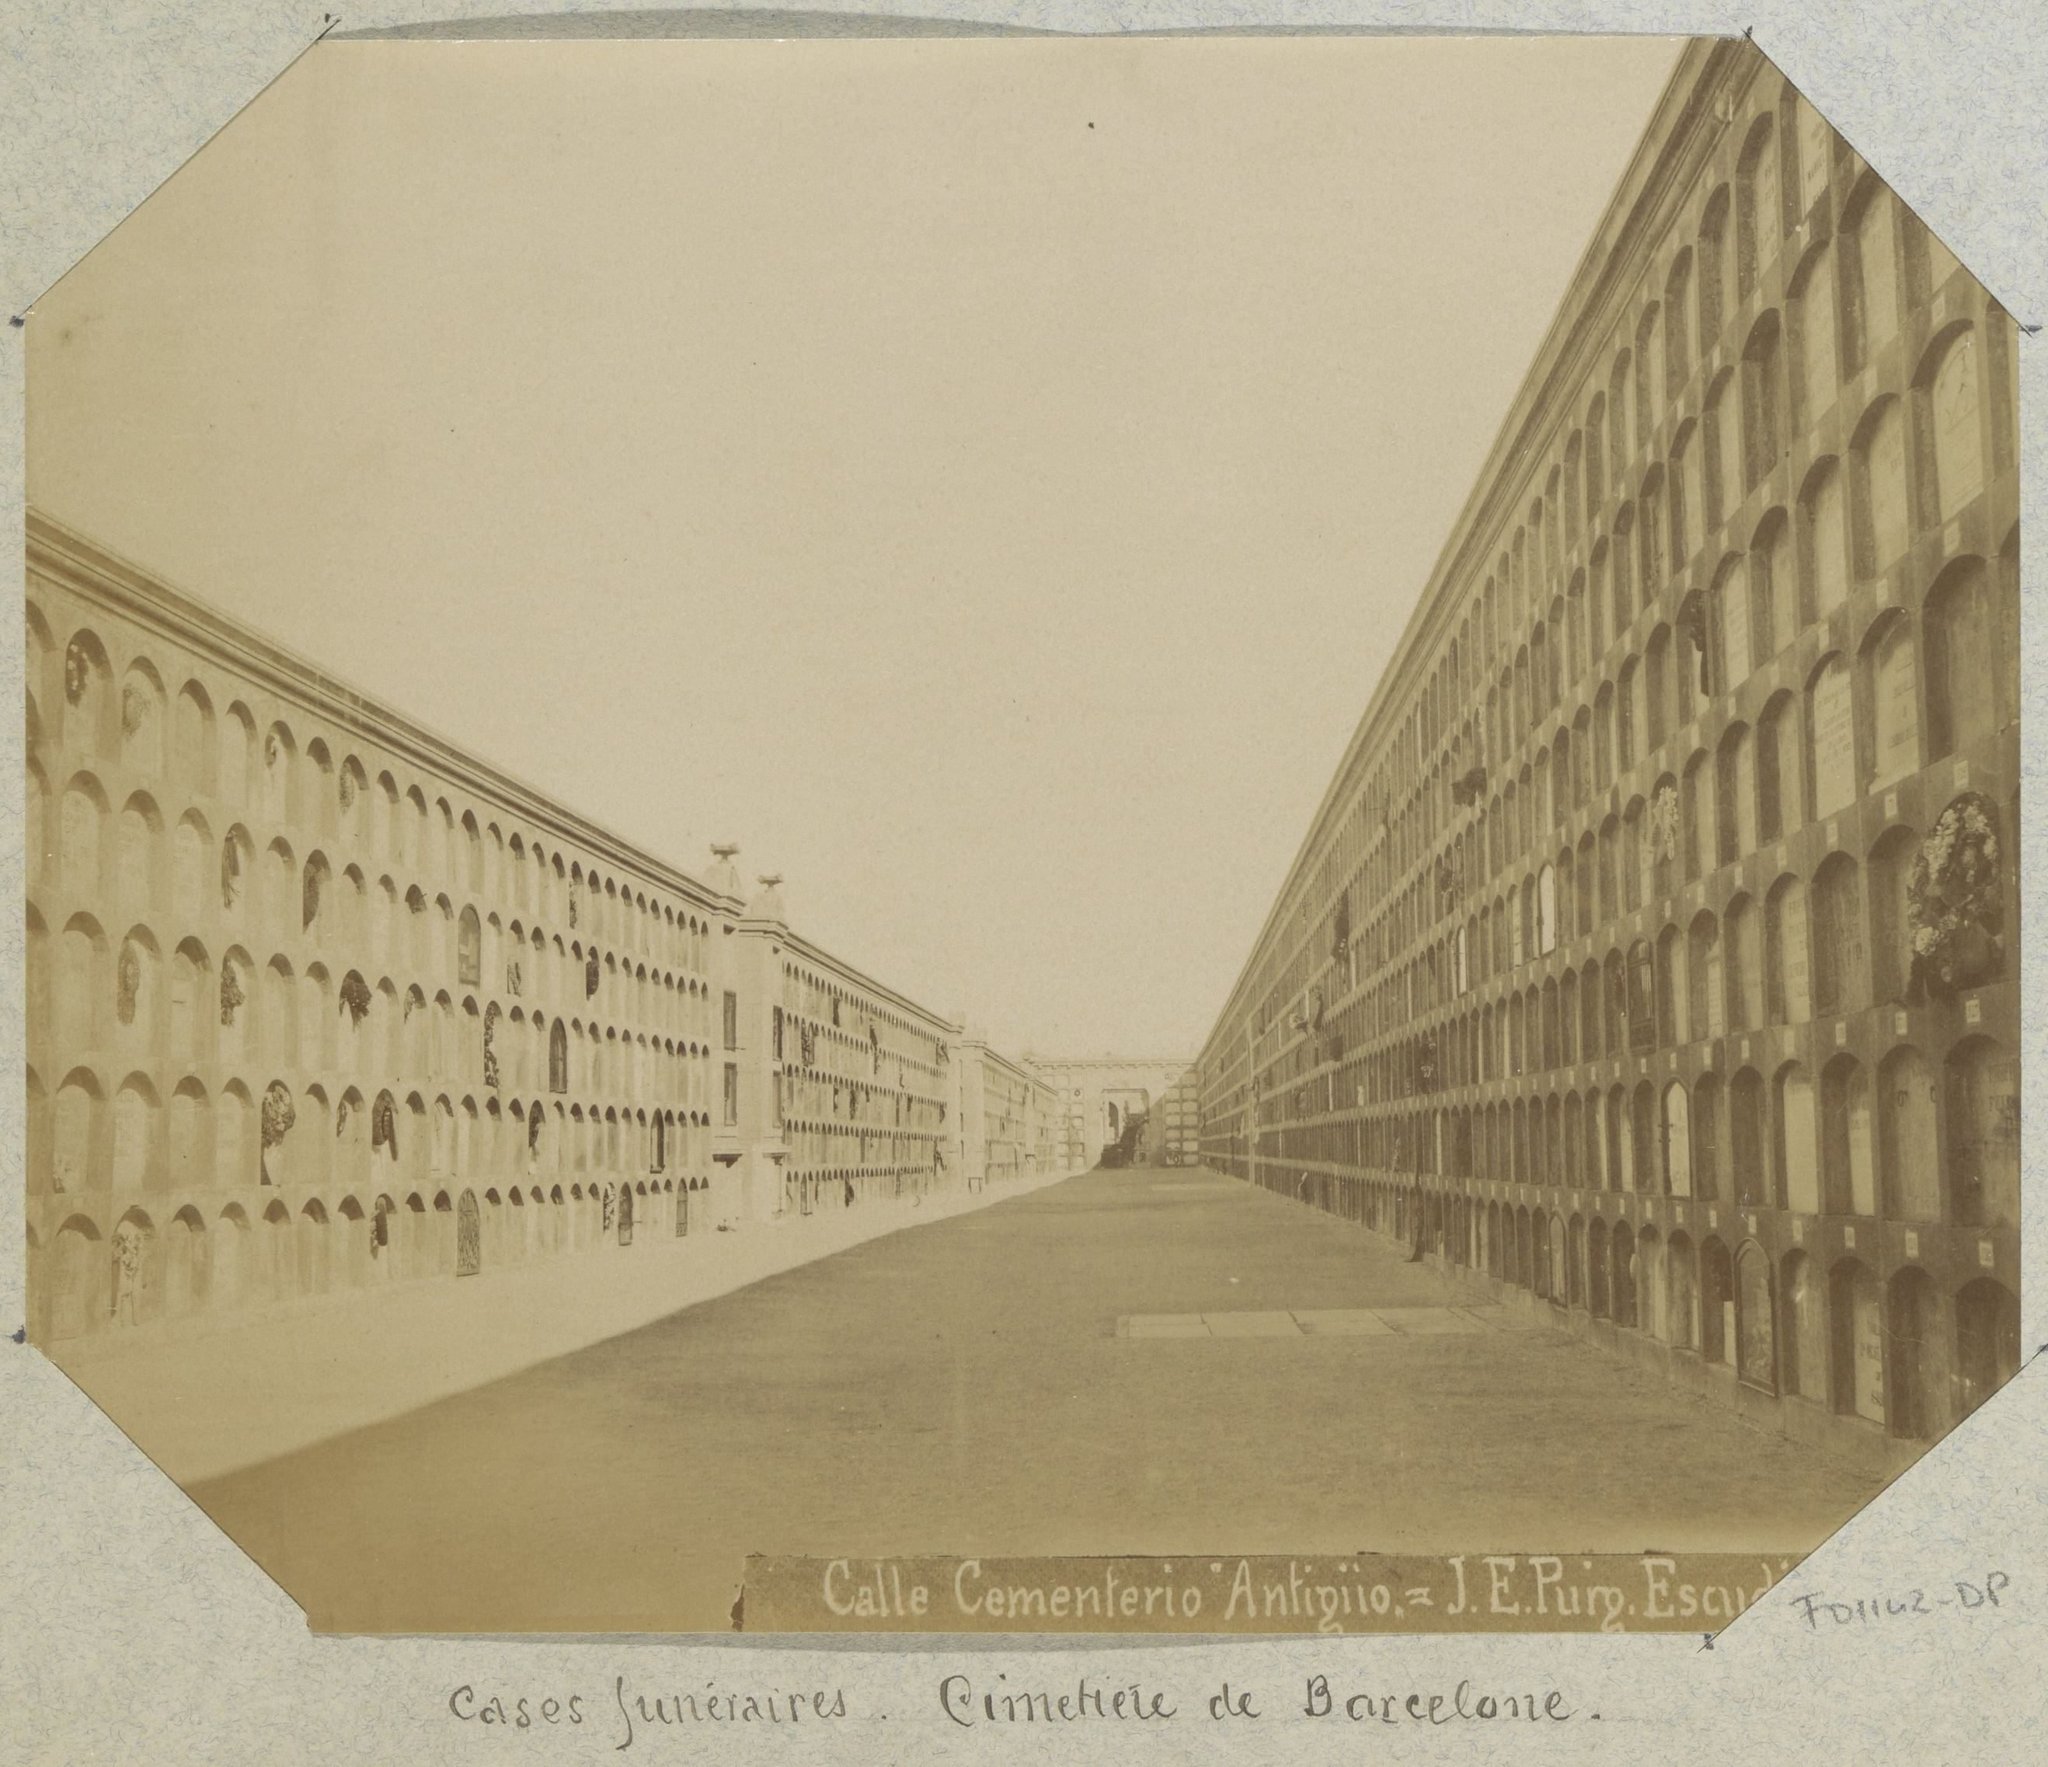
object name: album leaf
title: Grafmuren op het oude kerkhof van Barcelona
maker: josep esplugas puig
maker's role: fotograaf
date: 1880-1900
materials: paper, photographic support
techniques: albumen print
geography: barcelona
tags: niche-tomb, wall-tomb, churchyard, cemetery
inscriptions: address: ‘Escudillers.89.’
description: Onderdeel van Album van een Franse amateur met foto's van Frankrijk, Algerije, Palmyra, de Wereldtentoonstelling van 1900 en van bekende Fransen.